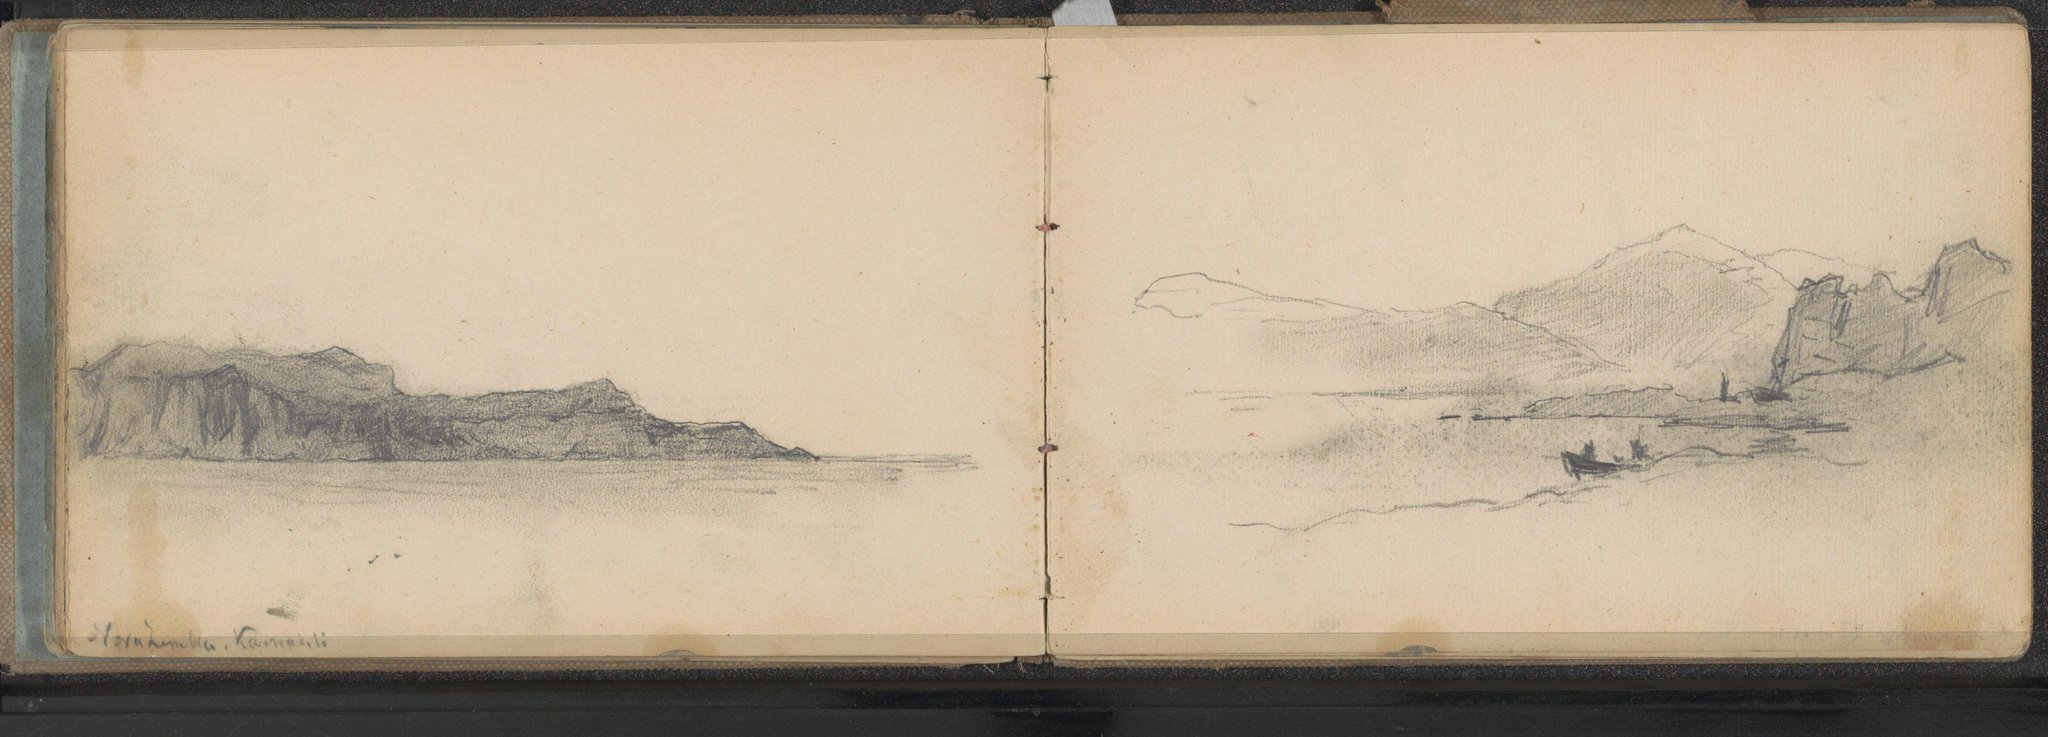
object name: sketchbook leaf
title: Gezicht op de kustlijn van Nova Zembla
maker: louis apol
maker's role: draughtsman, painter, print maker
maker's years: 1850-1936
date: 1880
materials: paper, pencil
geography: novaya zemlya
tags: coast (in polar regions), rowing-boat, canoe, etc.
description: In de branding een bemande roeiboot. Blad 28 recto uit een schetsboek met 35 bladen betekend tijdens de expeditie naar Nova Zembla in 1880.